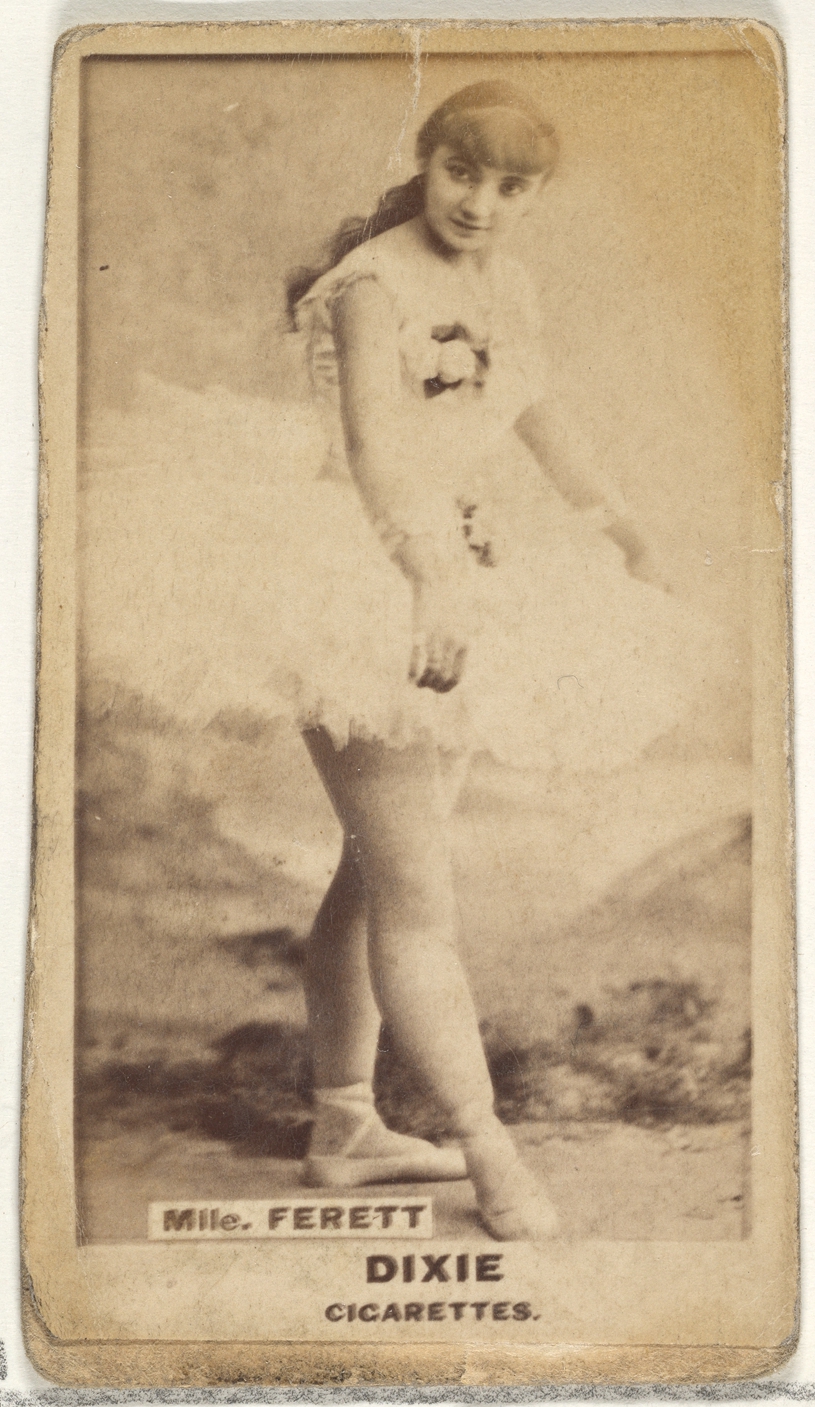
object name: photograph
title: Mlle. Ferett, from the Actors and Actresses series (N45, Type 1) for Dixie Cigarettes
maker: allen & ginter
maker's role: publisher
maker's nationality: american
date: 1888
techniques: albumen silver print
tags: portraits,women,actresses